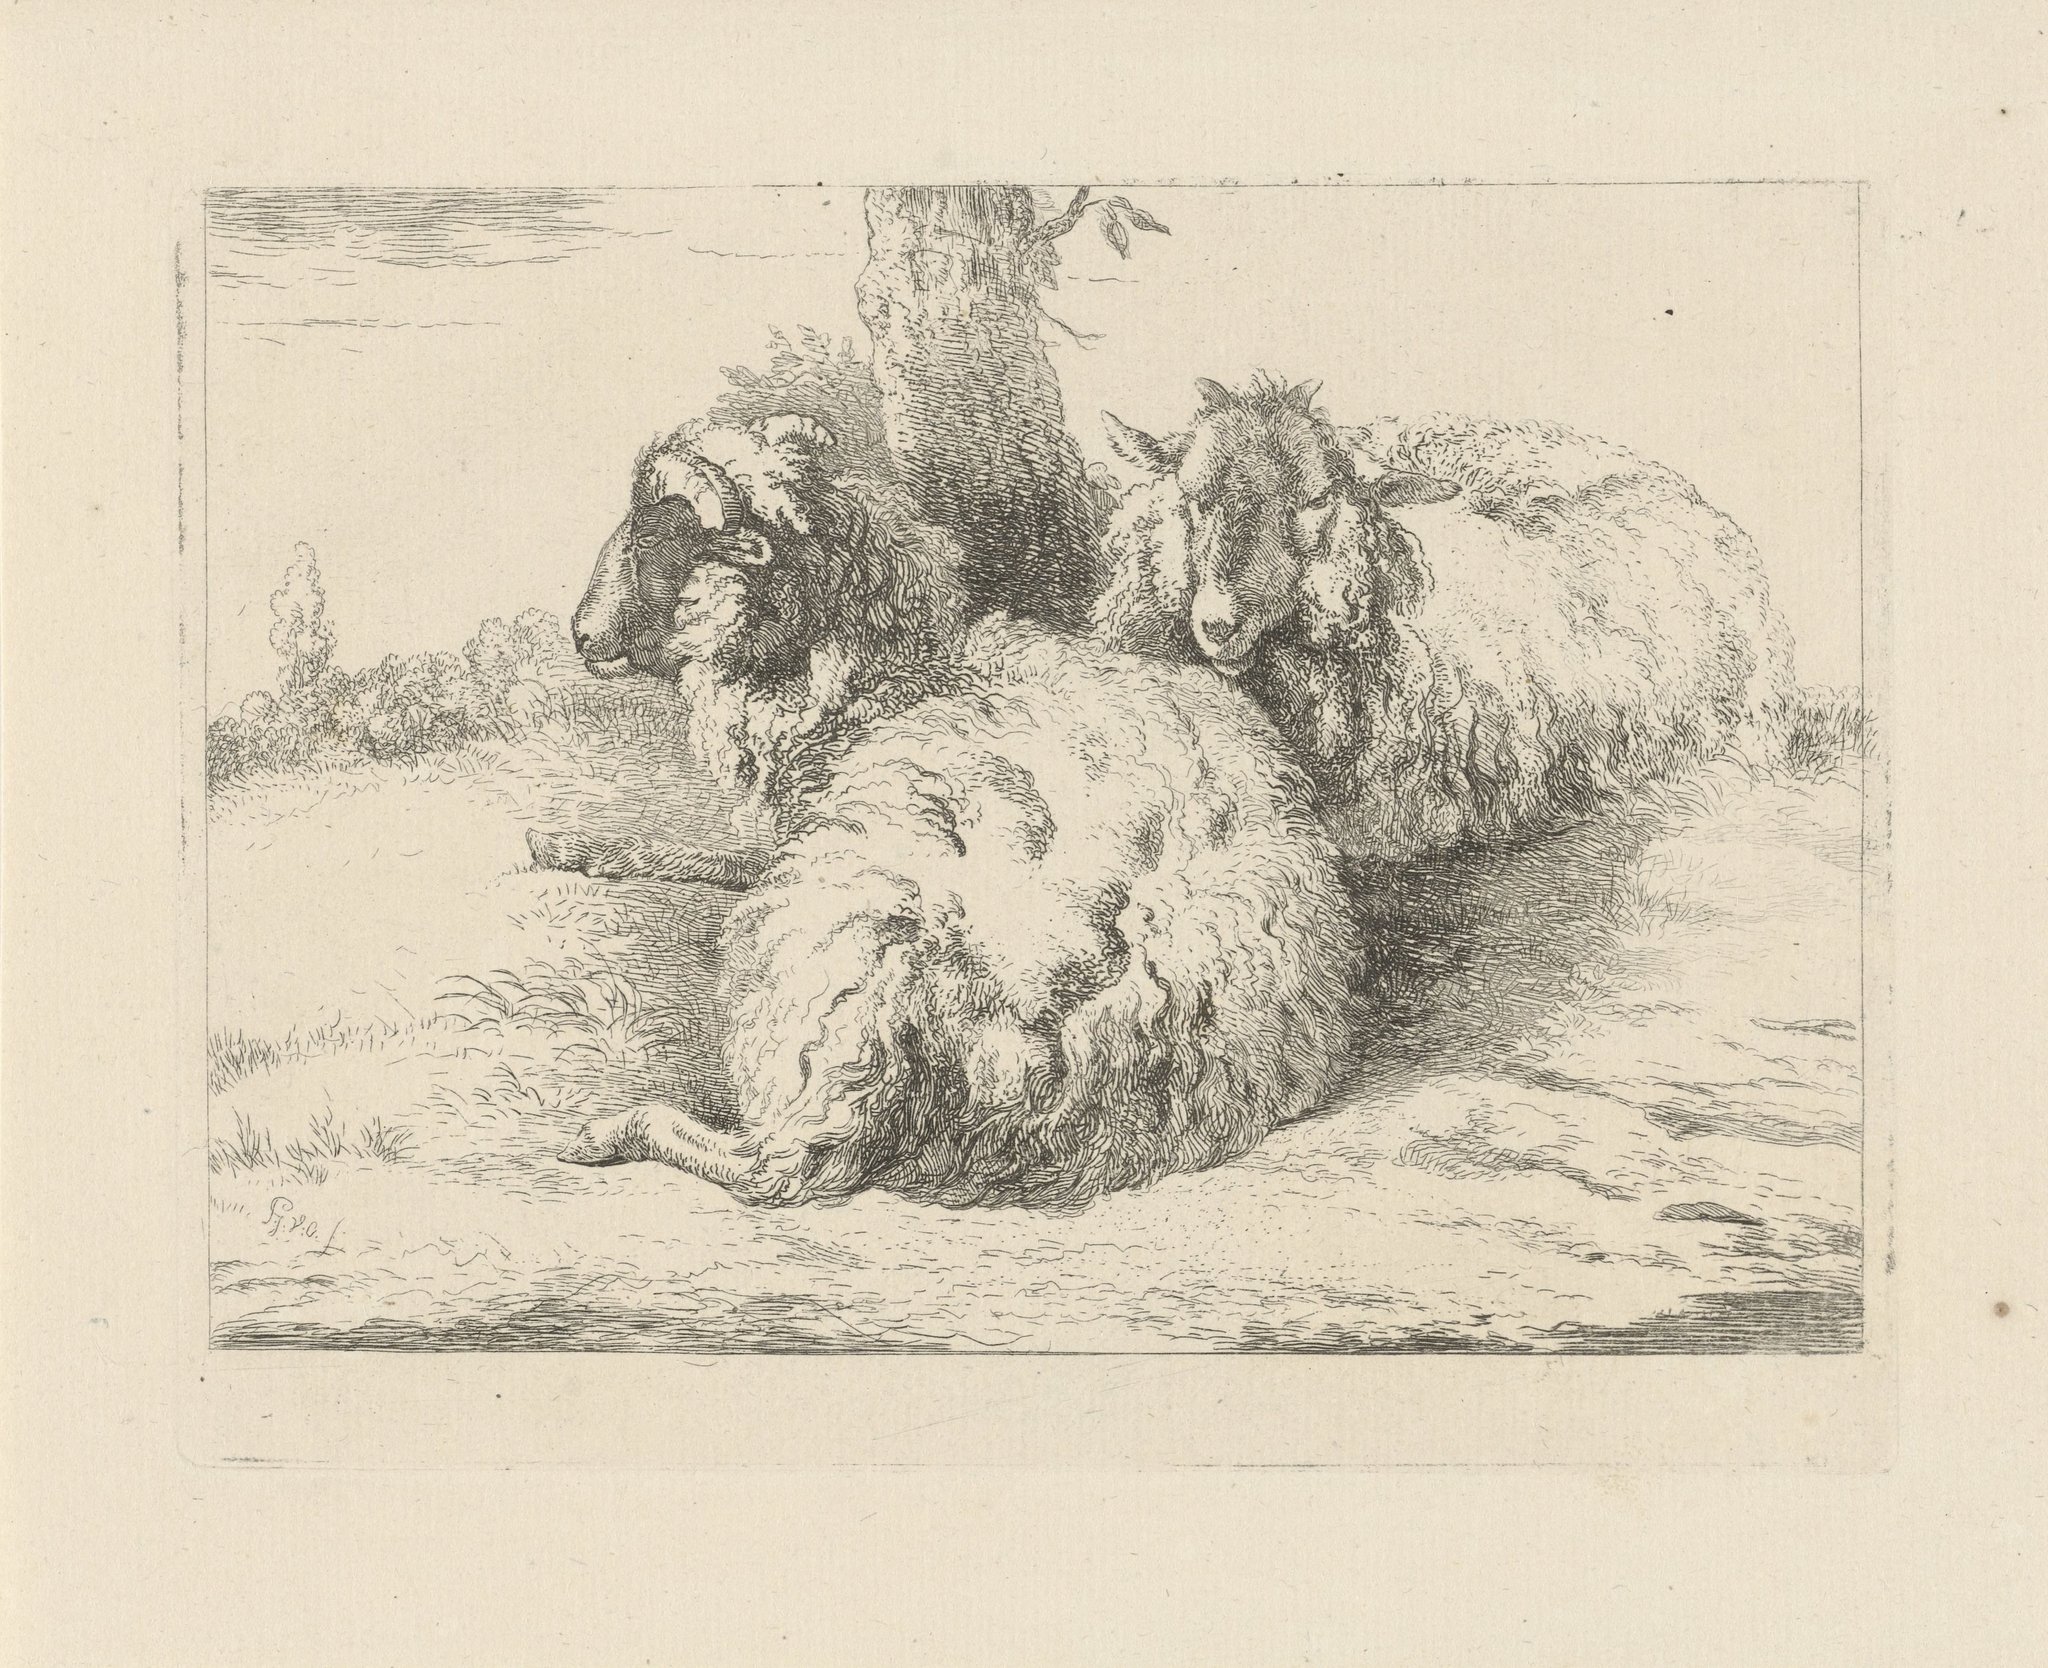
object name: print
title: Liggende schapen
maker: pieter gerardus van os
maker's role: draughtsman, painter, print maker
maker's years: 1776-1839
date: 1791-1839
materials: paper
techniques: etching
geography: netherlands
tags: sheep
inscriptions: collector's mark: Lugt 2228